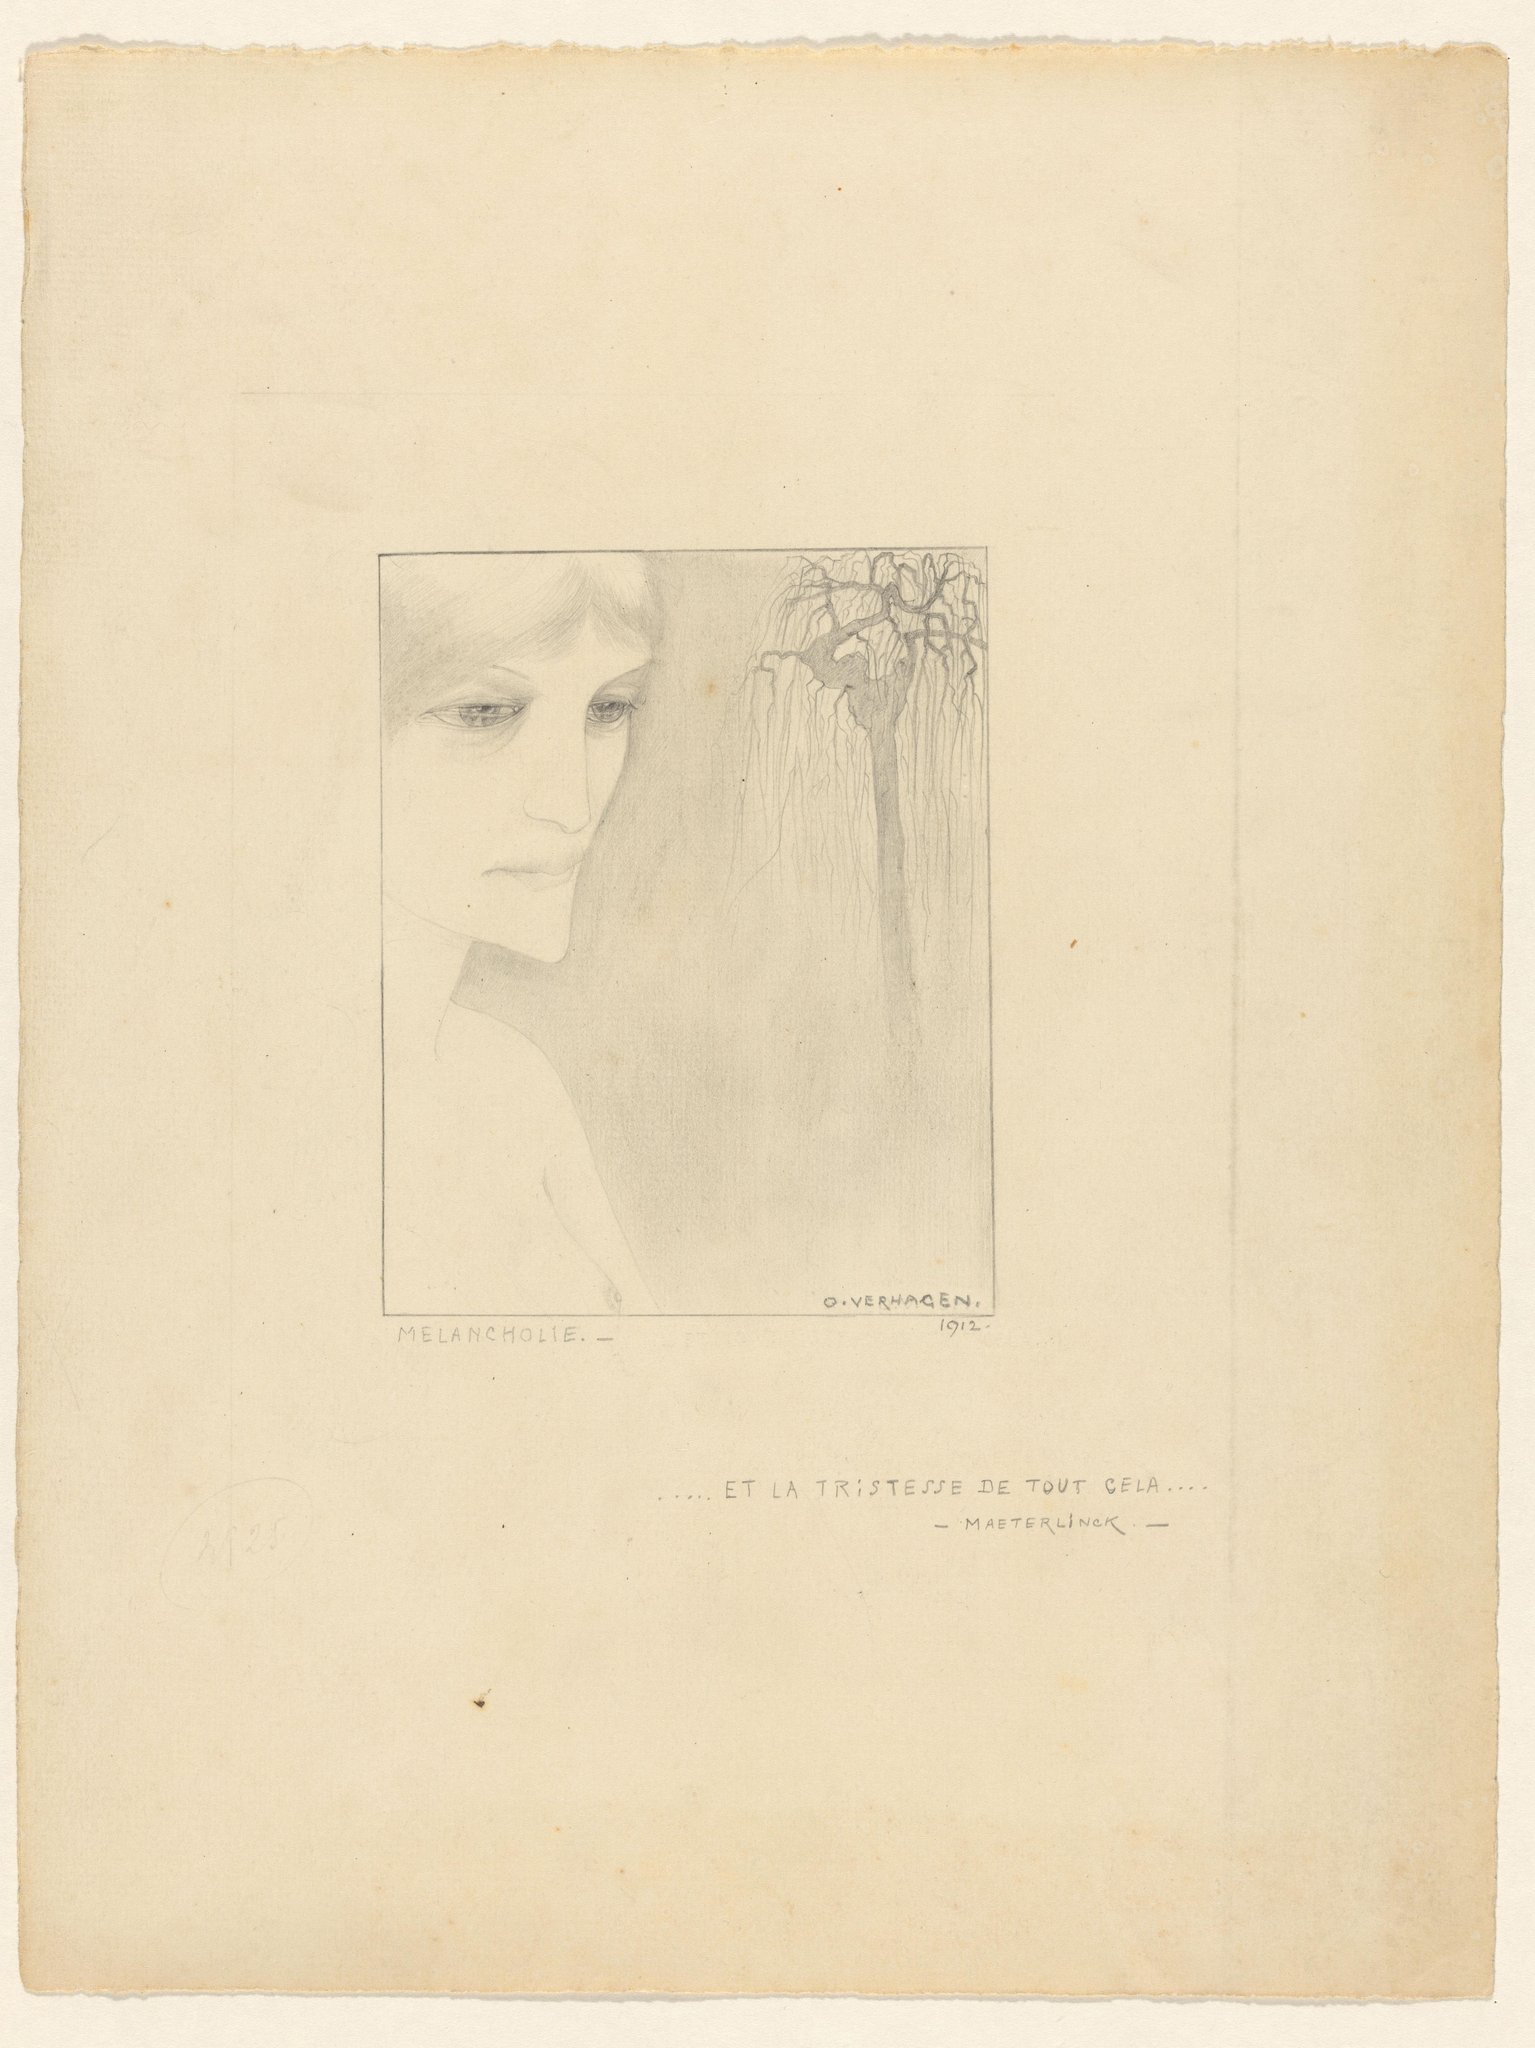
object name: drawing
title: Melancholie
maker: otto verhagen (i)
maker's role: draughtsman, print maker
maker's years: 1885-1951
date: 1912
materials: paper, pencil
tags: face, trees, 'malenconico (per la terra)', 'malinconia' (ripa)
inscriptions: collector's mark: Lugt 2228